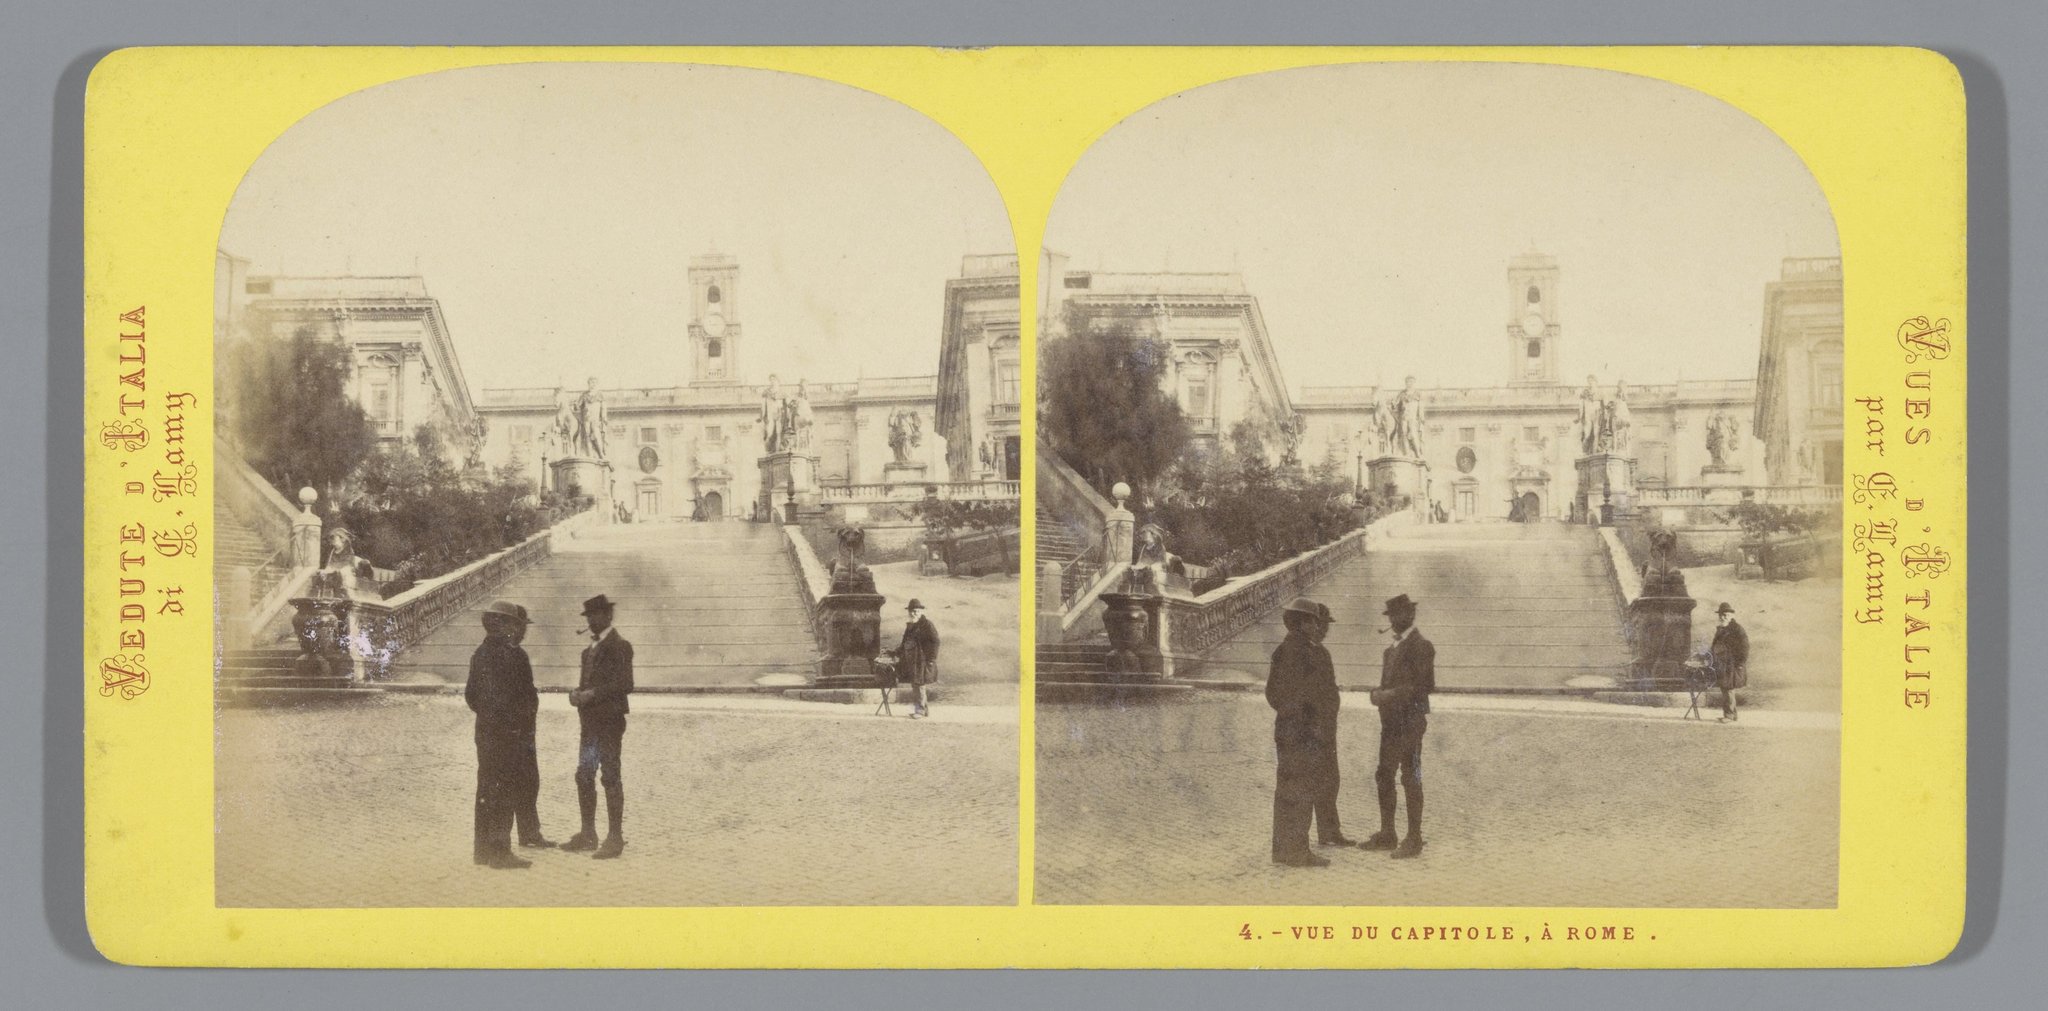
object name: stereograph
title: Vedute d'Italia / Vues d'Italie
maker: ernest eléonor pierre lamy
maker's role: publisher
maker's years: 1828-1900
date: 1861-1878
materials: cardboard, paper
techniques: albumen print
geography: rome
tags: monument, statue (+ city(-scape) with figures, staffage), palace, front steps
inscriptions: number: ‘4.’